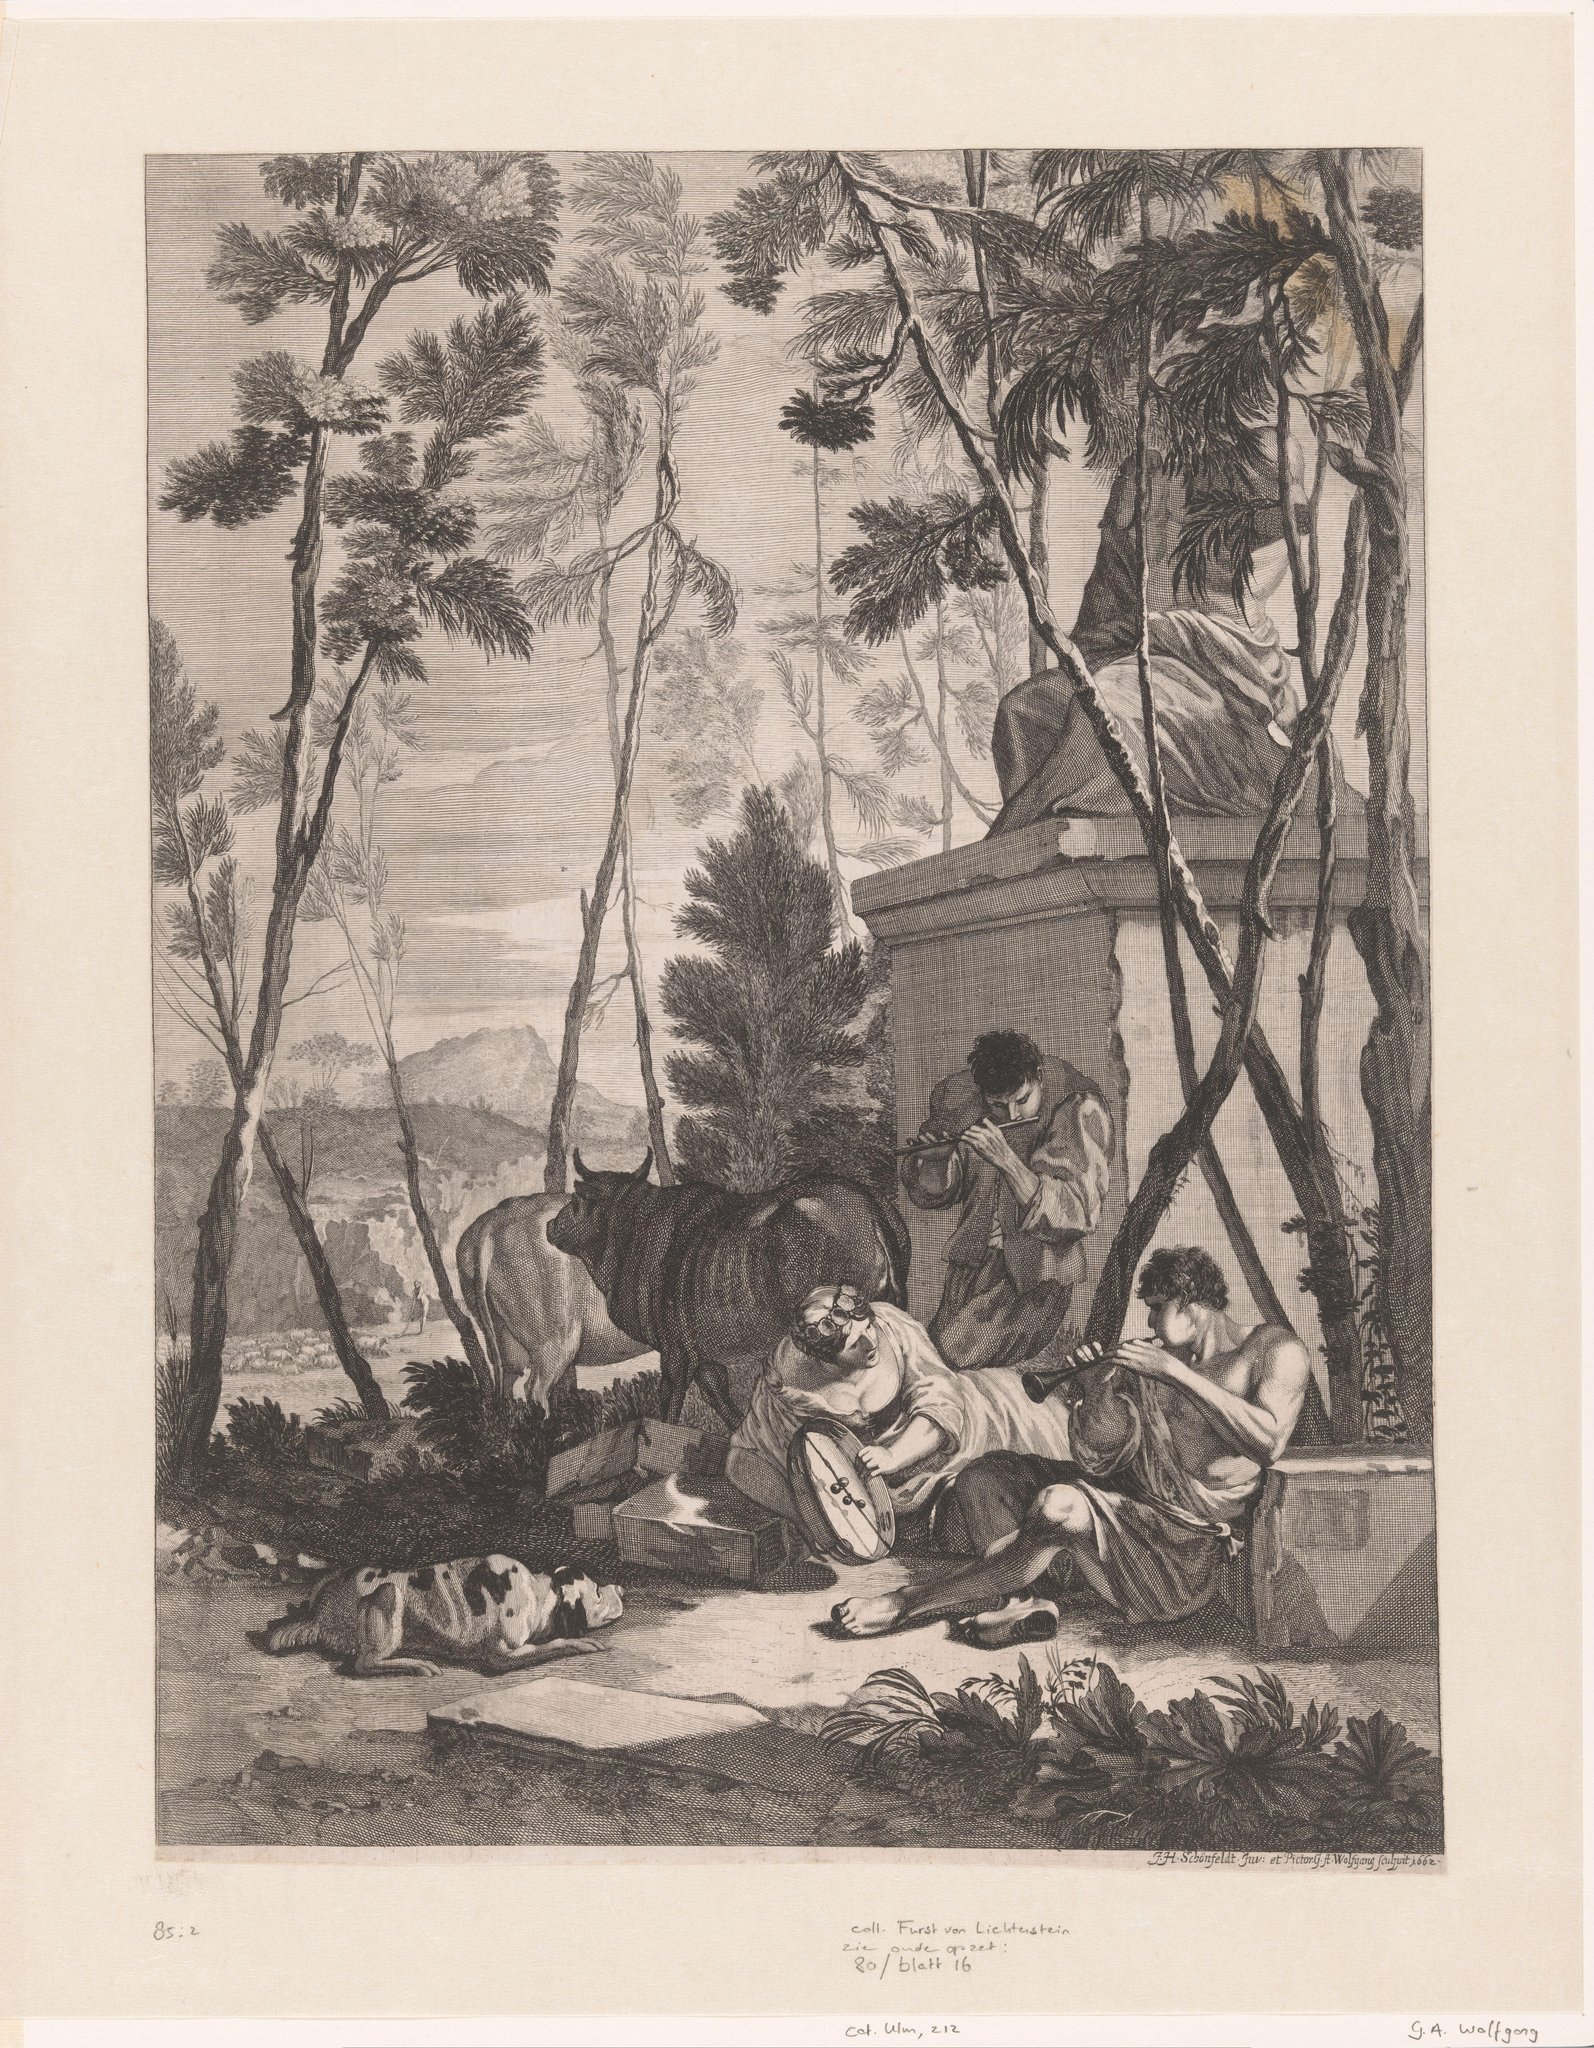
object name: print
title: Musicerende herders in een landschap bij een sculptuur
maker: georg andreas wolfgang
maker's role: goldsmith, print maker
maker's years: 1631-1716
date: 1662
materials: paper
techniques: etching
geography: germany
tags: tambourine - cc - out of doors, landscapes, herding, herdsman, herdswoman, shepherd, shepherdess, cowherd, etc., wind instruments - cc - out of doors, piece of sculpture, reproduction of a piece of sculpture, dog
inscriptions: collector's mark: Lugt 2760, collector's mark: Lugt 2228